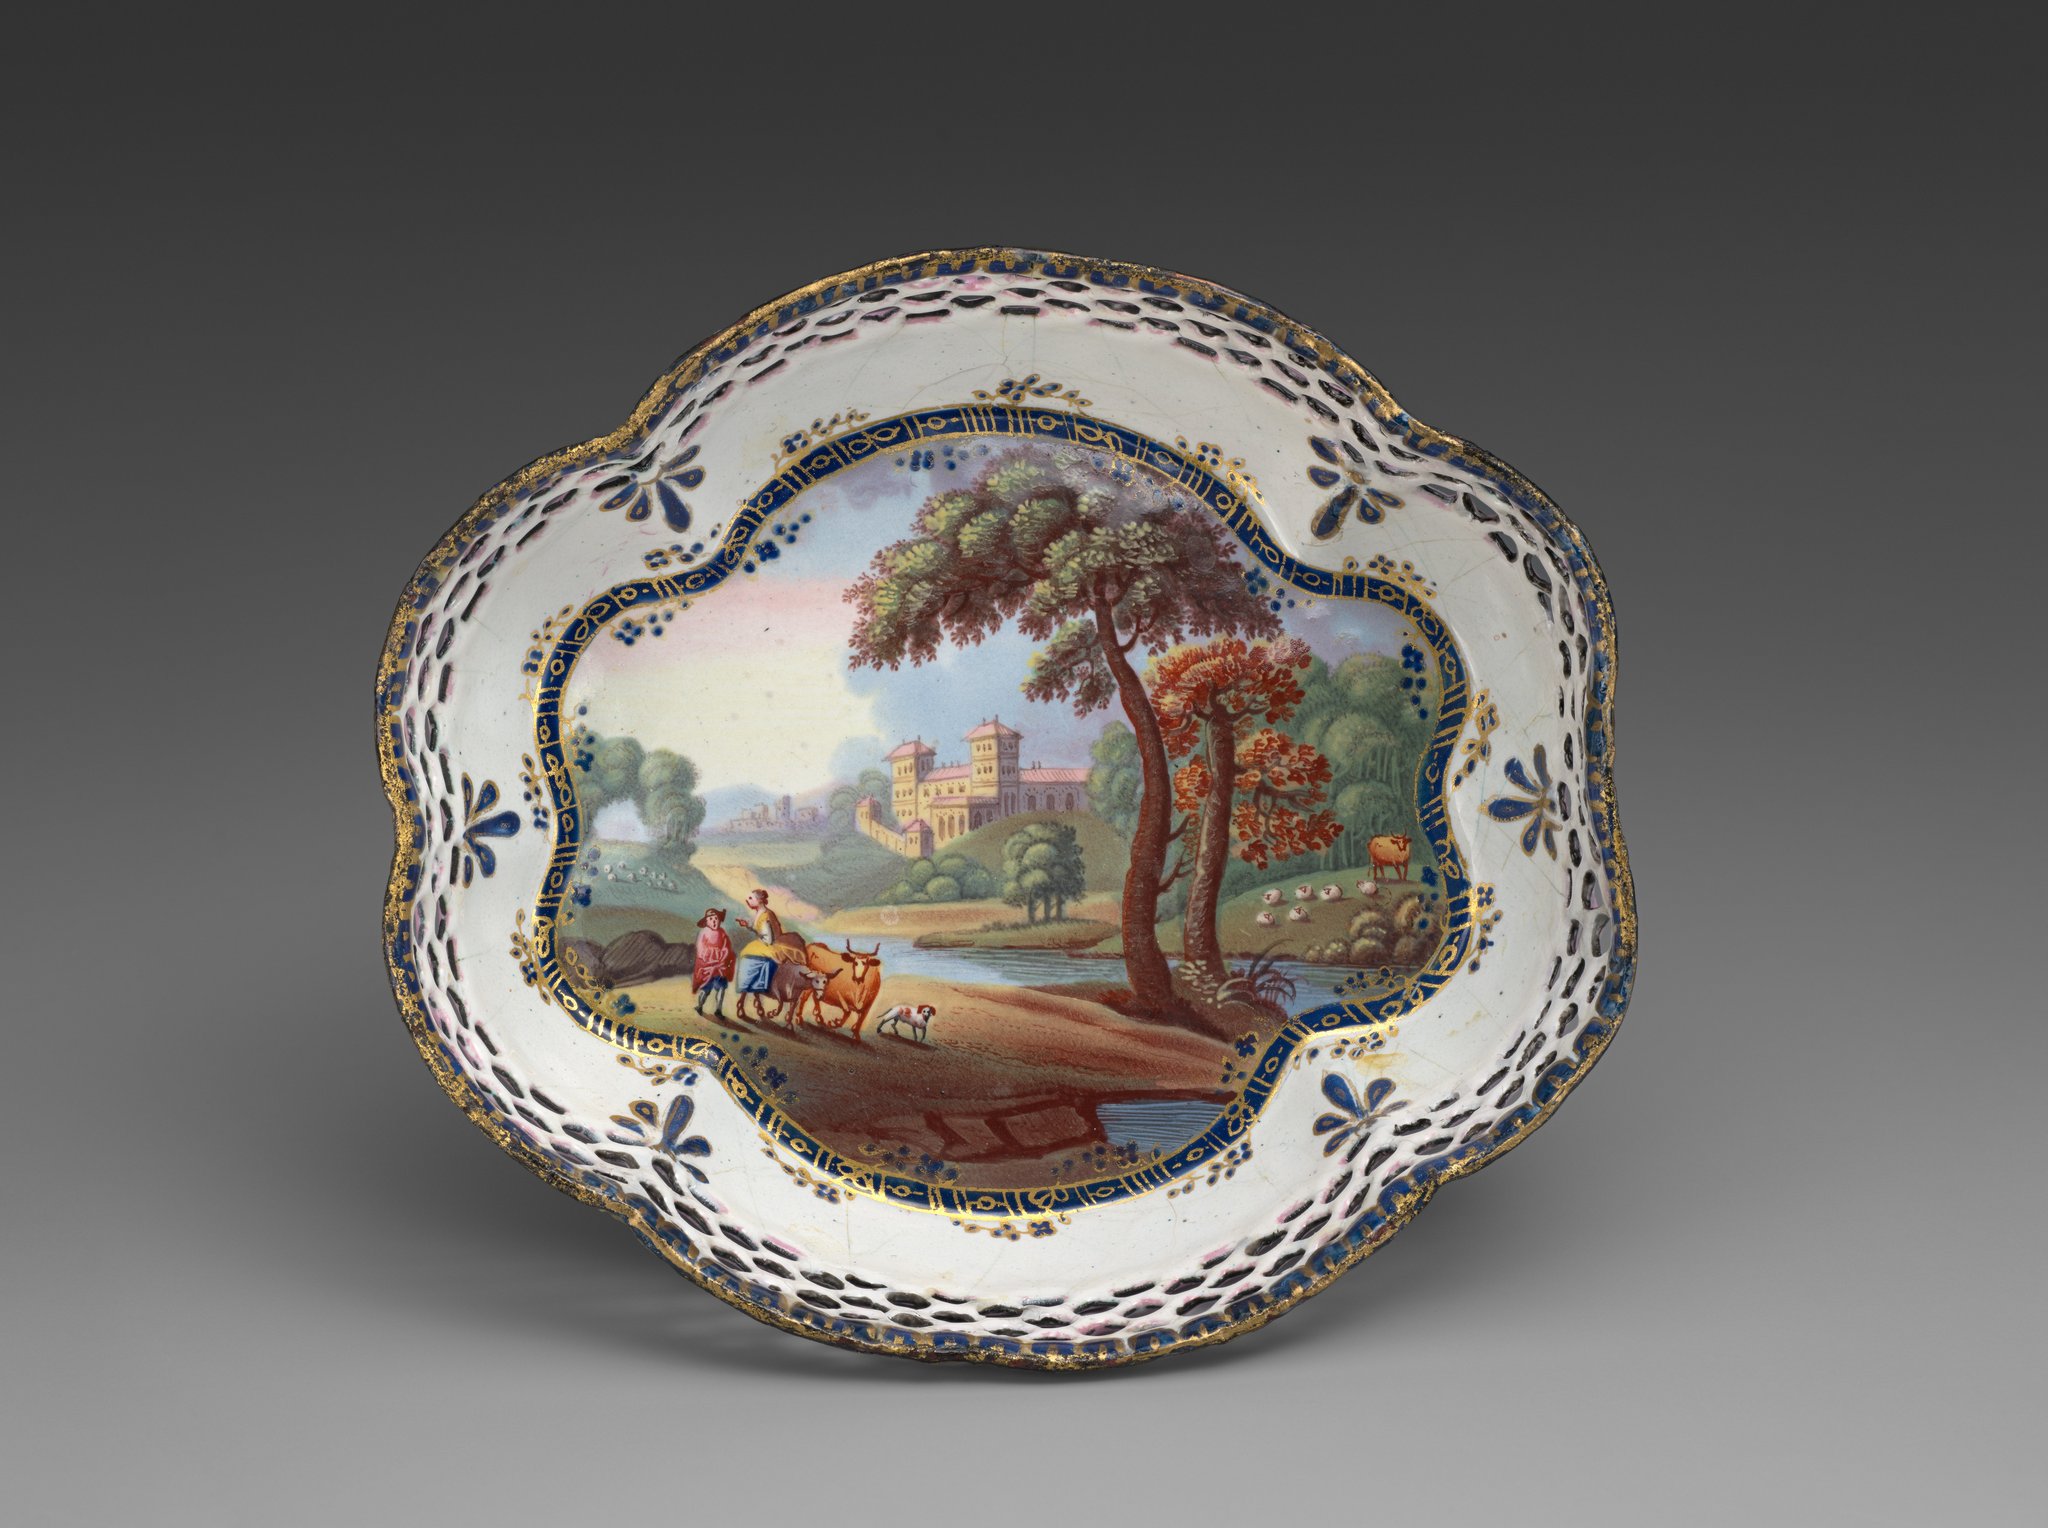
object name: counter tray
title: Counter tray for the "kitty" in the card game of Quadrille (part of a set)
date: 1770-1775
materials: copper, enamel